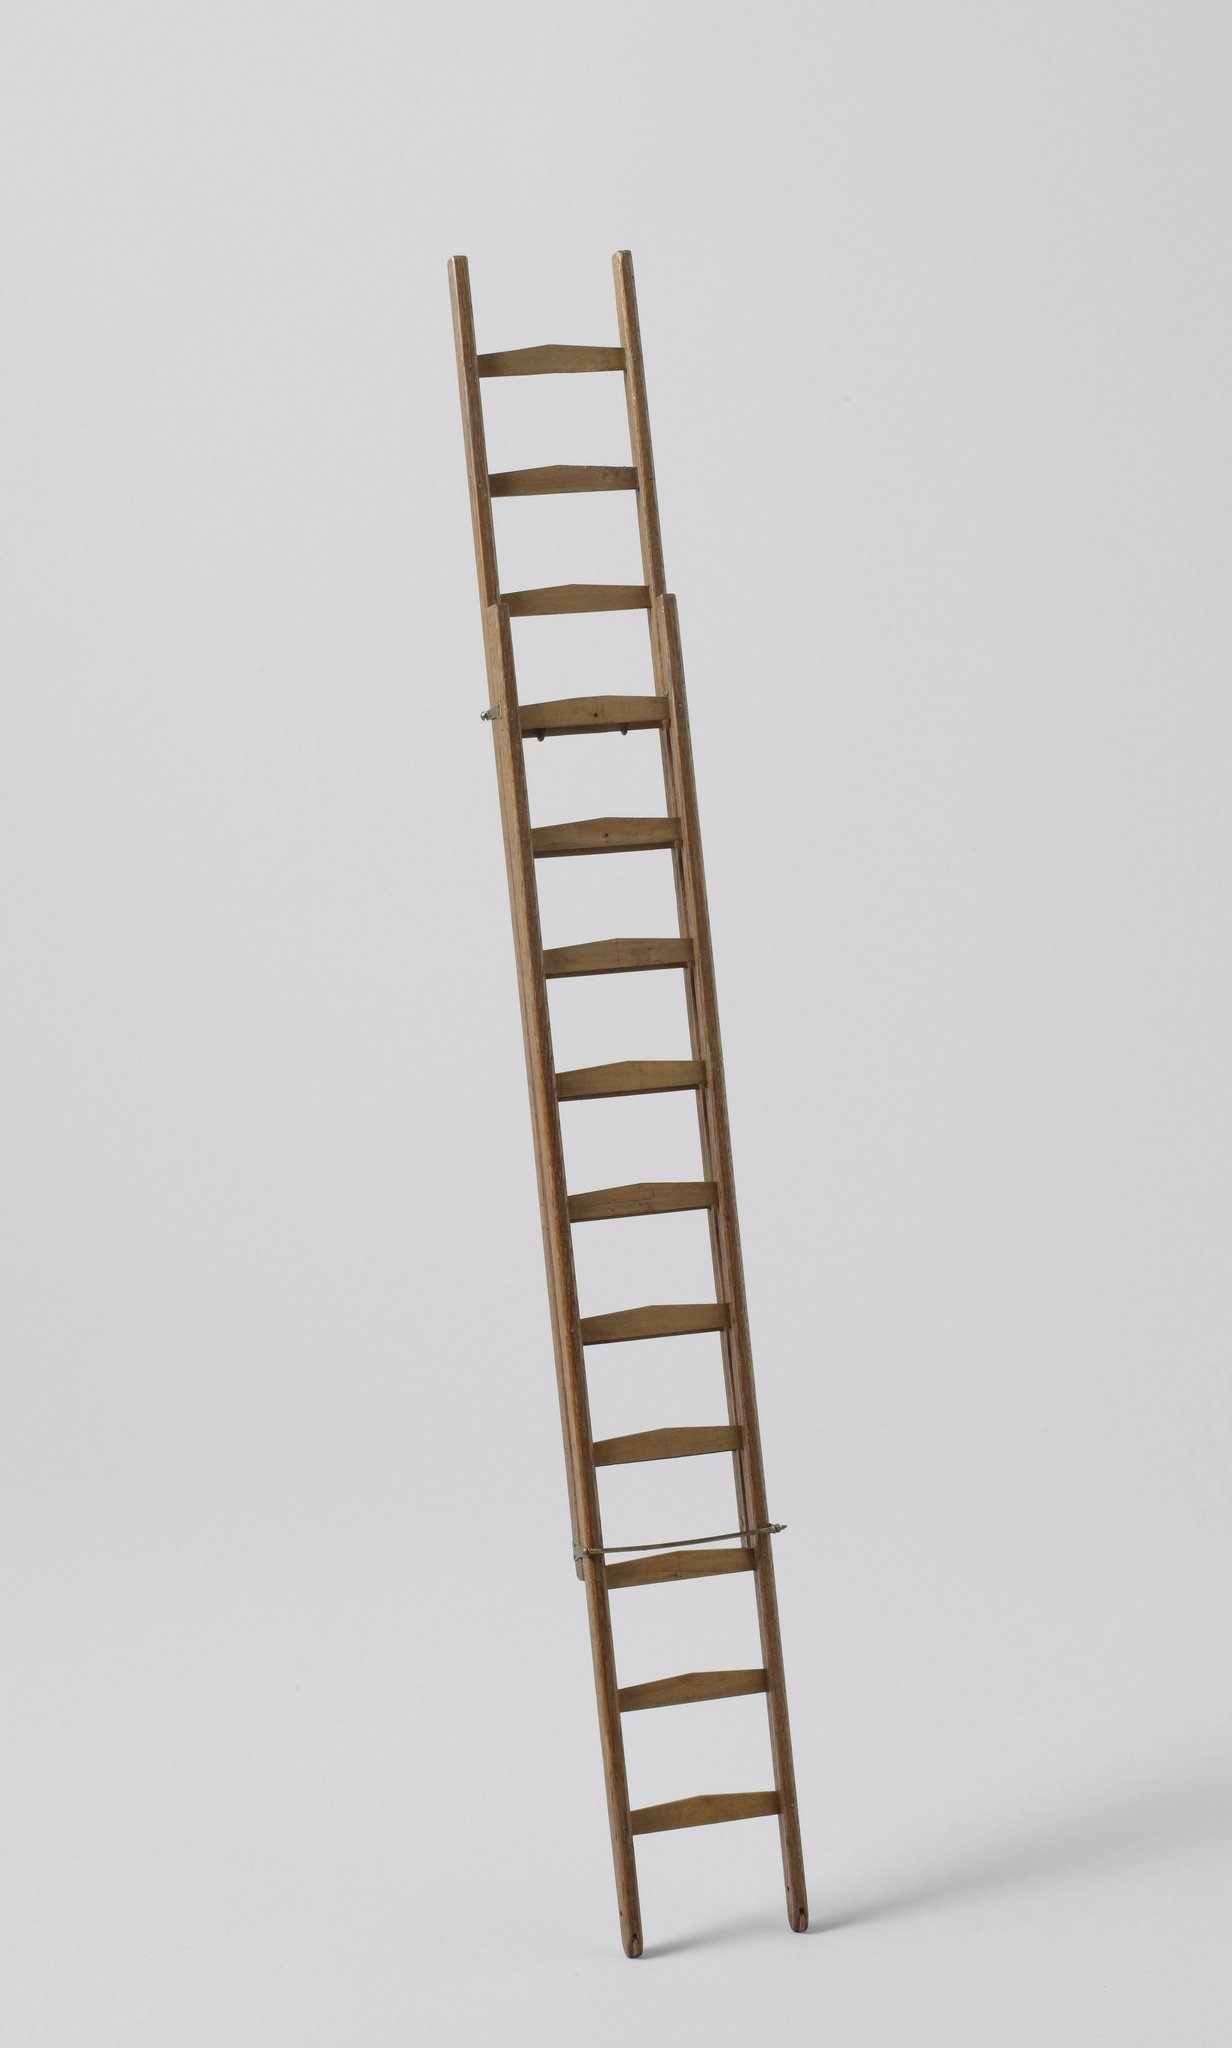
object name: demonstration model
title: Model of a Ladder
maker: petrus van der loo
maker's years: 1806-1864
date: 1850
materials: brass, wood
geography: the hague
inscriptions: inscription, on a rung: ‘No 6’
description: Model van een eenvoudige tweedelige werkladder. Het uitschuifbare gedeelte heeft een wieltje bovenaan iedere poot. Twee haken aan de beugel van het uitschuifbare gedeelte kunnen om de sporten van het onderdeel worden geslagen om het terugschuiven te beletten.